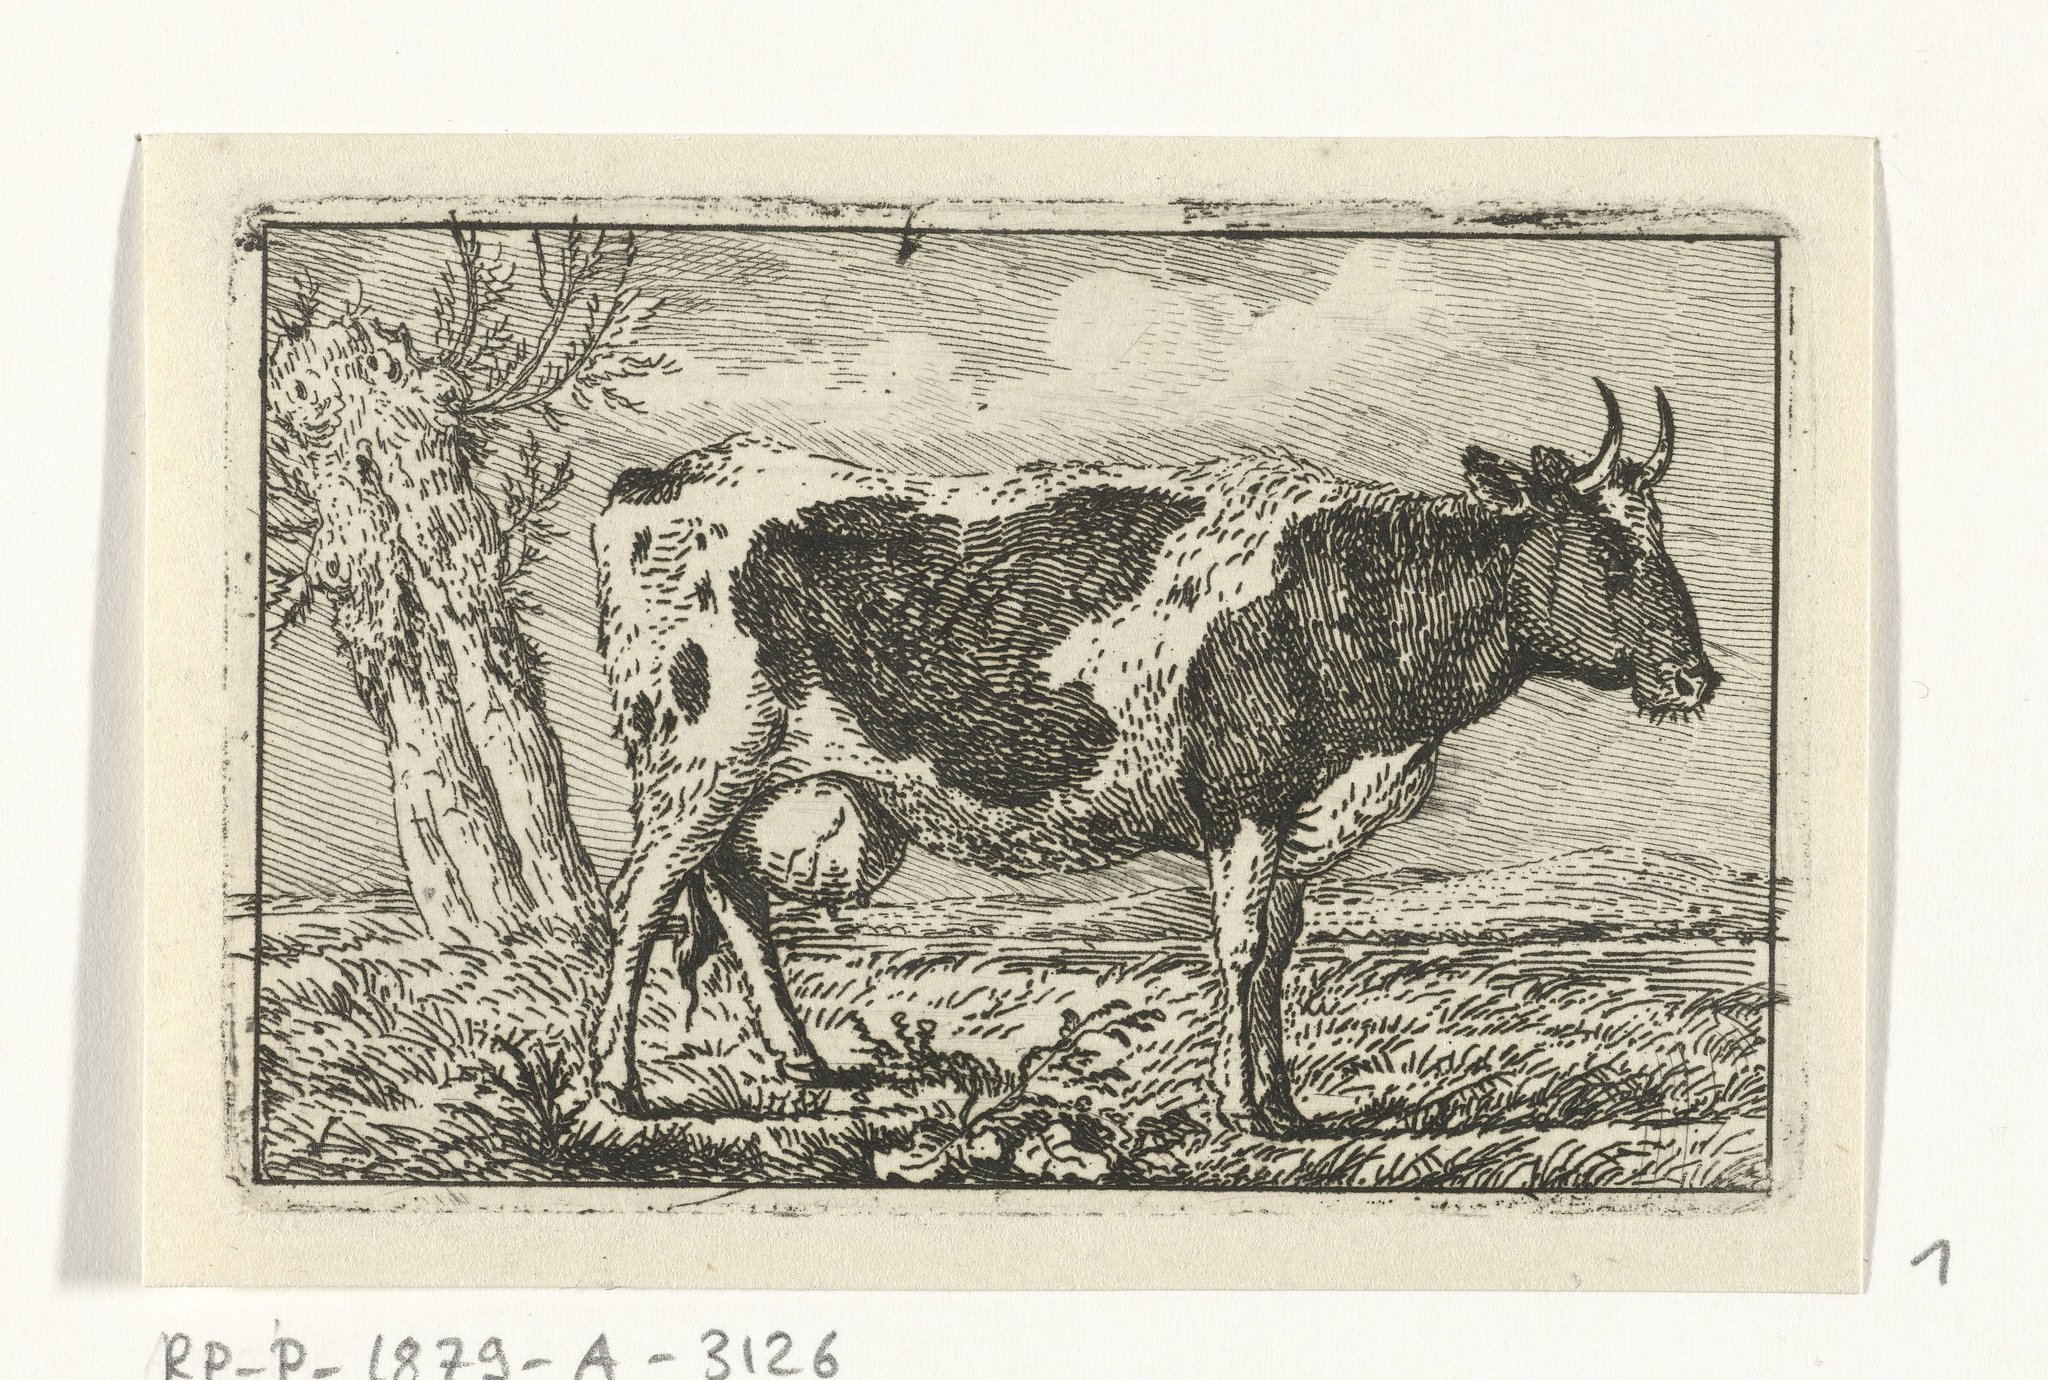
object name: print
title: Koeien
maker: anthony oberman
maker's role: draughtsman, painter, print maker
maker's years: 1781-1845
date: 1796-1845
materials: paper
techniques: etching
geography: amsterdam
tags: cow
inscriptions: collector's mark: Lugt 2228